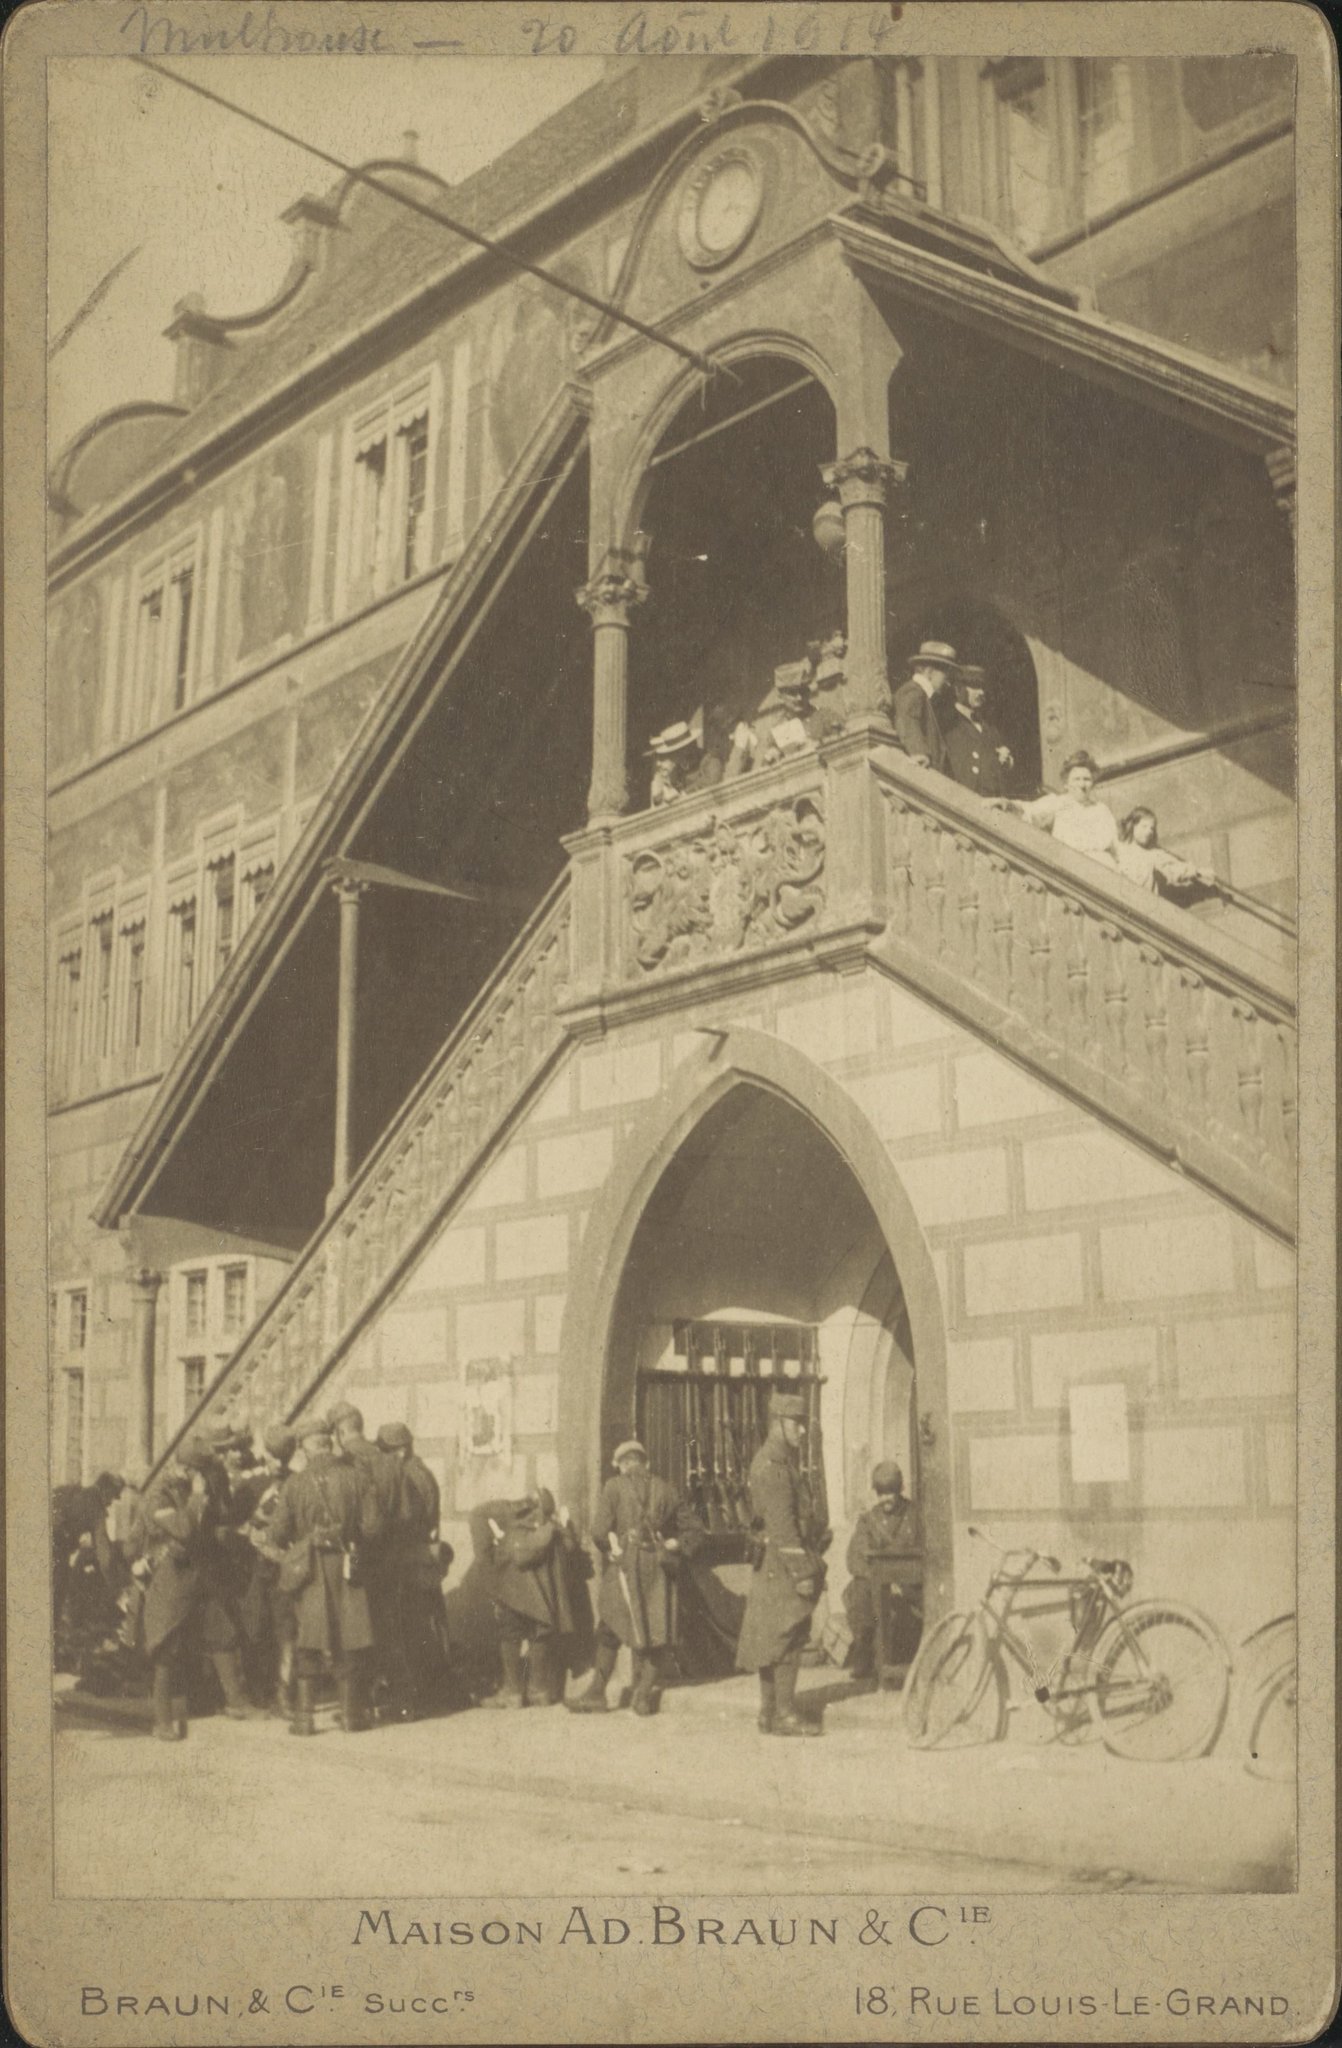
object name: photograph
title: Mobilisatie van Franse soldaten in Mulhouse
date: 1914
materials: cardboard, paper, photographic support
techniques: albumen print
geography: france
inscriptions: inscription: ‘Mulhouse - 20 Août 1914’, inscription: ‘MAISON AD. BRAUN 7 CIE. / BRAUN 7 CIE. SUCCESSEURS / 18, Rue Louis-le-Grand, 18 / (Avenue de l'Opéra) / 11, Bould des Italiens, 11 / PARIS / ON PEUT TOUJOURS AVOIR DES PORTRAITS DES / ANCIENNES MAISONS MAYER & PIERSON ET / PIERSON & BRAUN TOUS LES CLICHÉS AYANT / ÉTÉ SOIGNEUSEMENT CONSERVÉS. / LES PORTRAITS CARTES OU AUTRES PEUVENT / ETRE AGRANDIS JUSQU'A LA DIMENSION NATURE / LES PORTRAITS AU DESSUS DE 0M 20C SONT / TIRÉS AU PROCÉDÉ INALTÉRABLE. / B.P. GRIMAUD PARIS’, inscription: ‘MAISON AD. BRAUN 7 CIE. / BRAUN 7 CIE. SUCCRS / 18, RUE LOUIS-LE-GRAND’